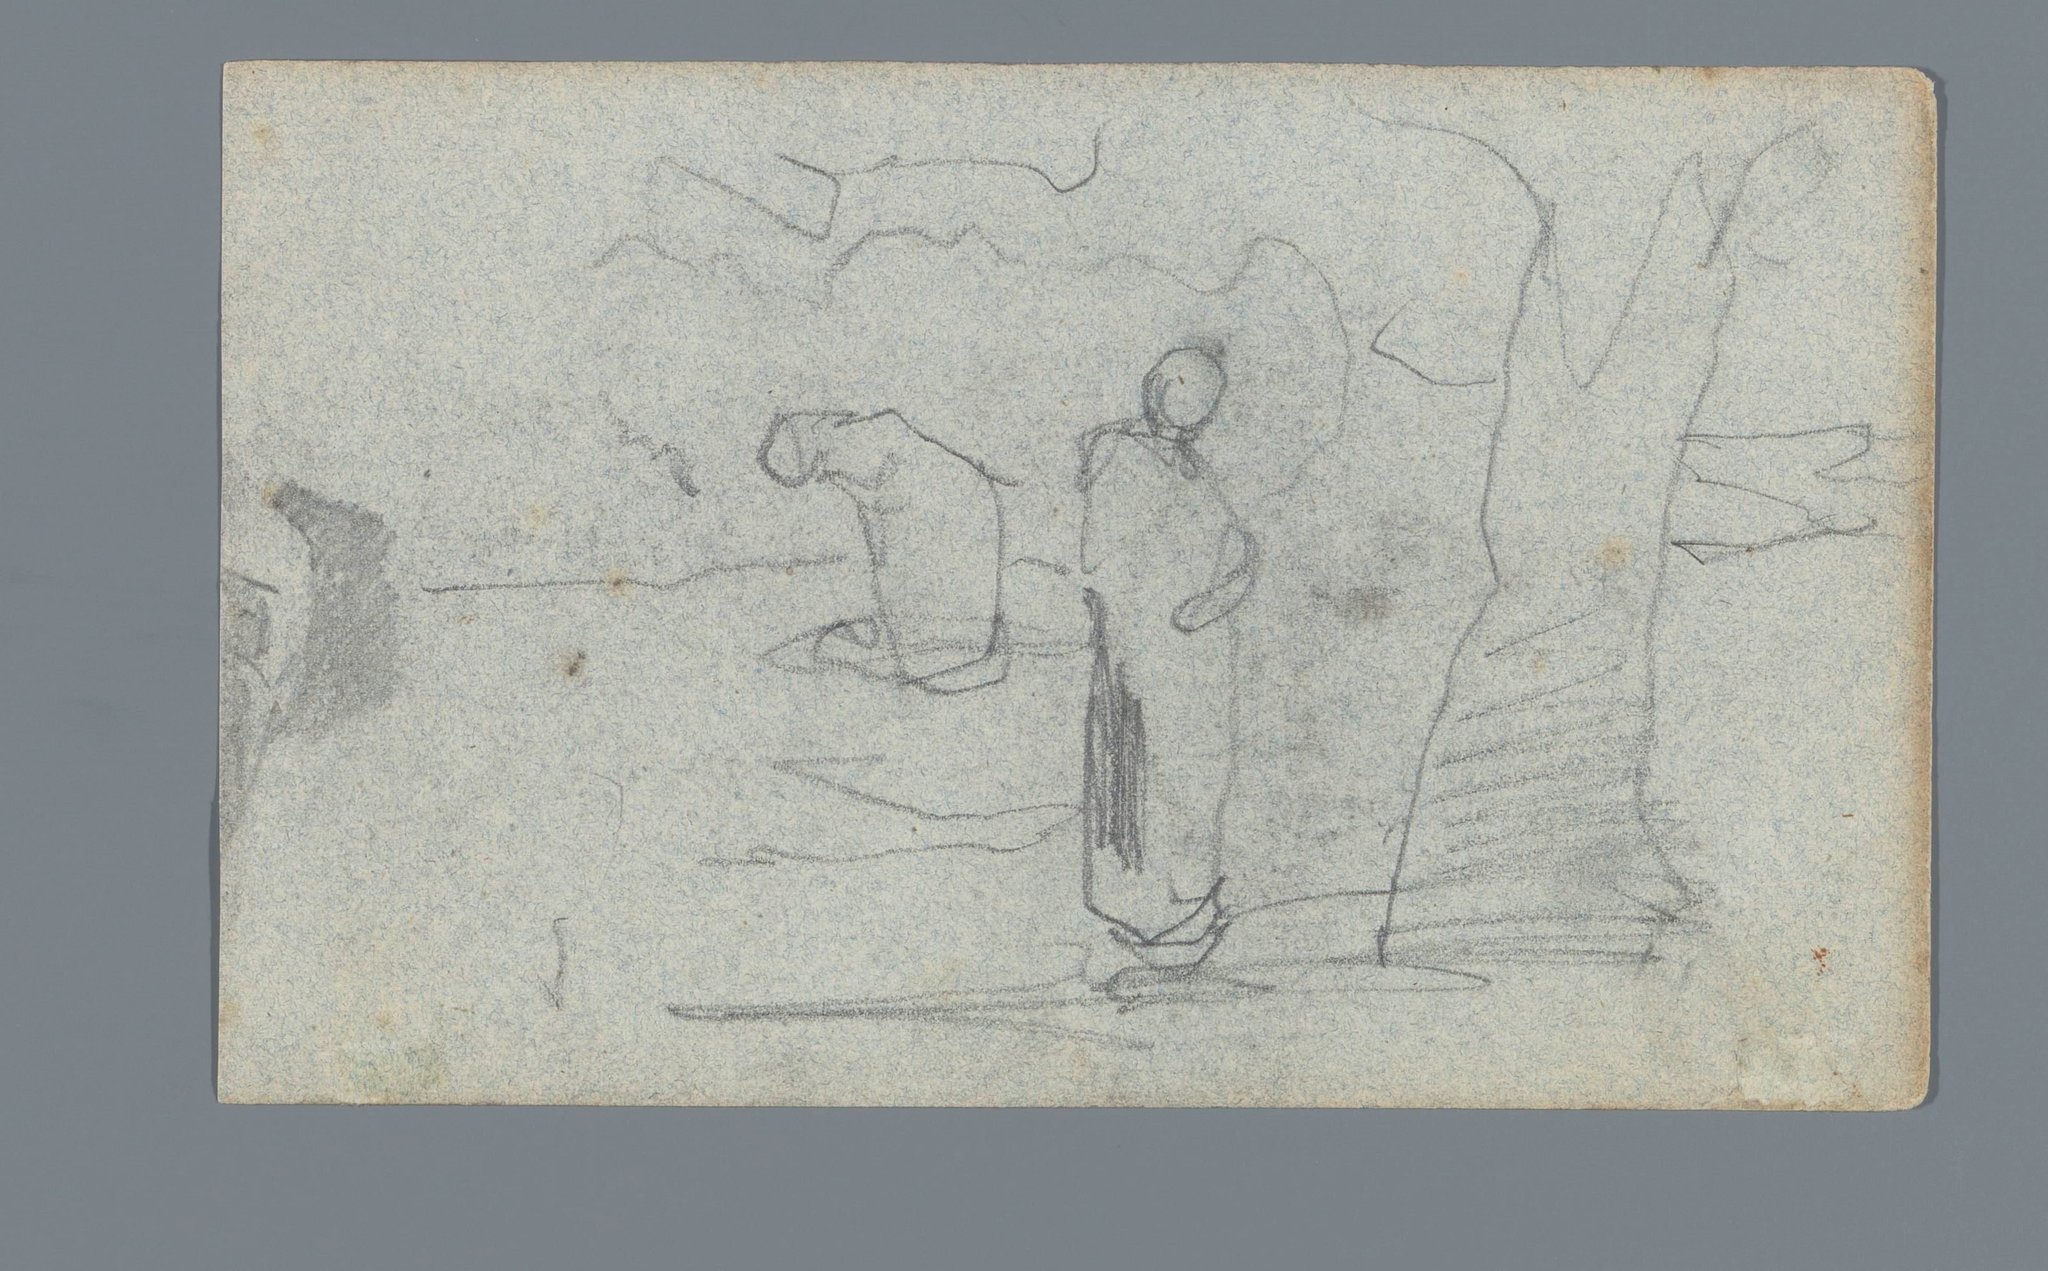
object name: drawing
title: Liggende kat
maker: george hendrik breitner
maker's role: draughtsman, painter, print maker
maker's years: 1857-1923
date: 1880-1882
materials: paper, pencil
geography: rotterdam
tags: cat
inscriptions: collector's mark: Lugt 2228, workshop stamp: Lugt 291d